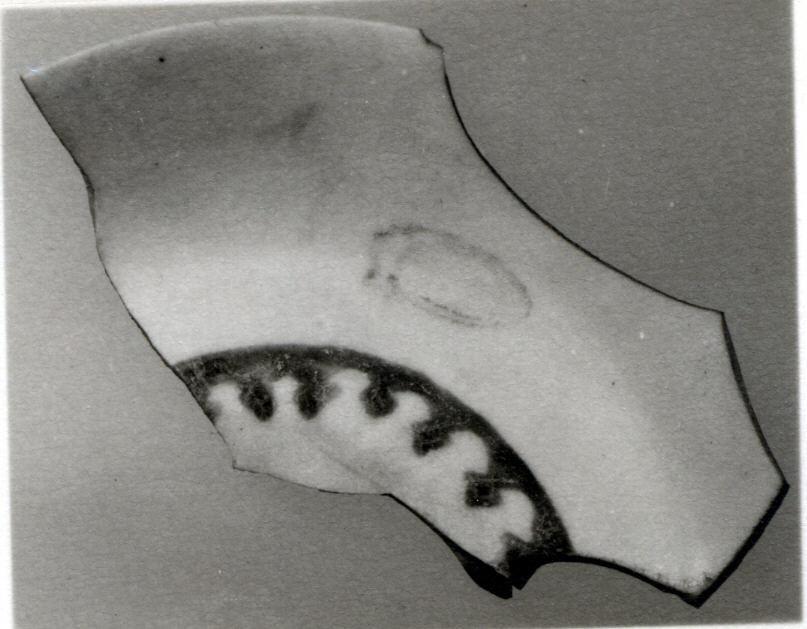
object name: fragment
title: Ceramic Fragment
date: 1501-1600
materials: earthenware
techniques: glazing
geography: iran